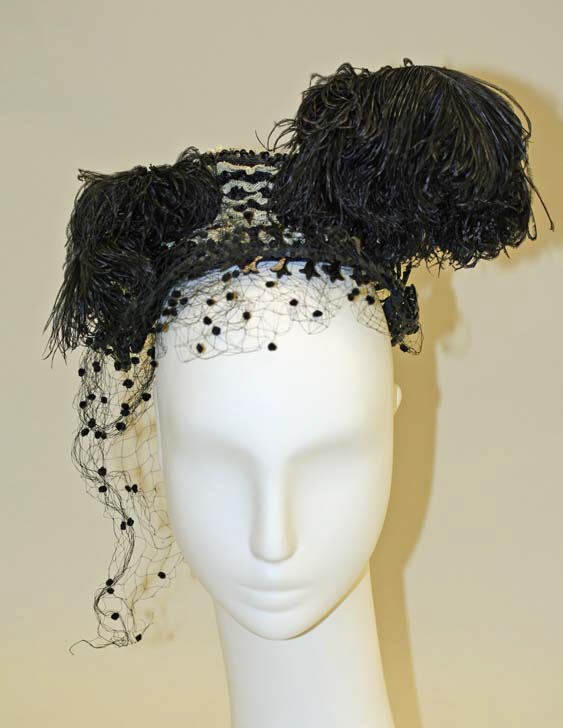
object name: evening hat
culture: american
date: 1867-1900